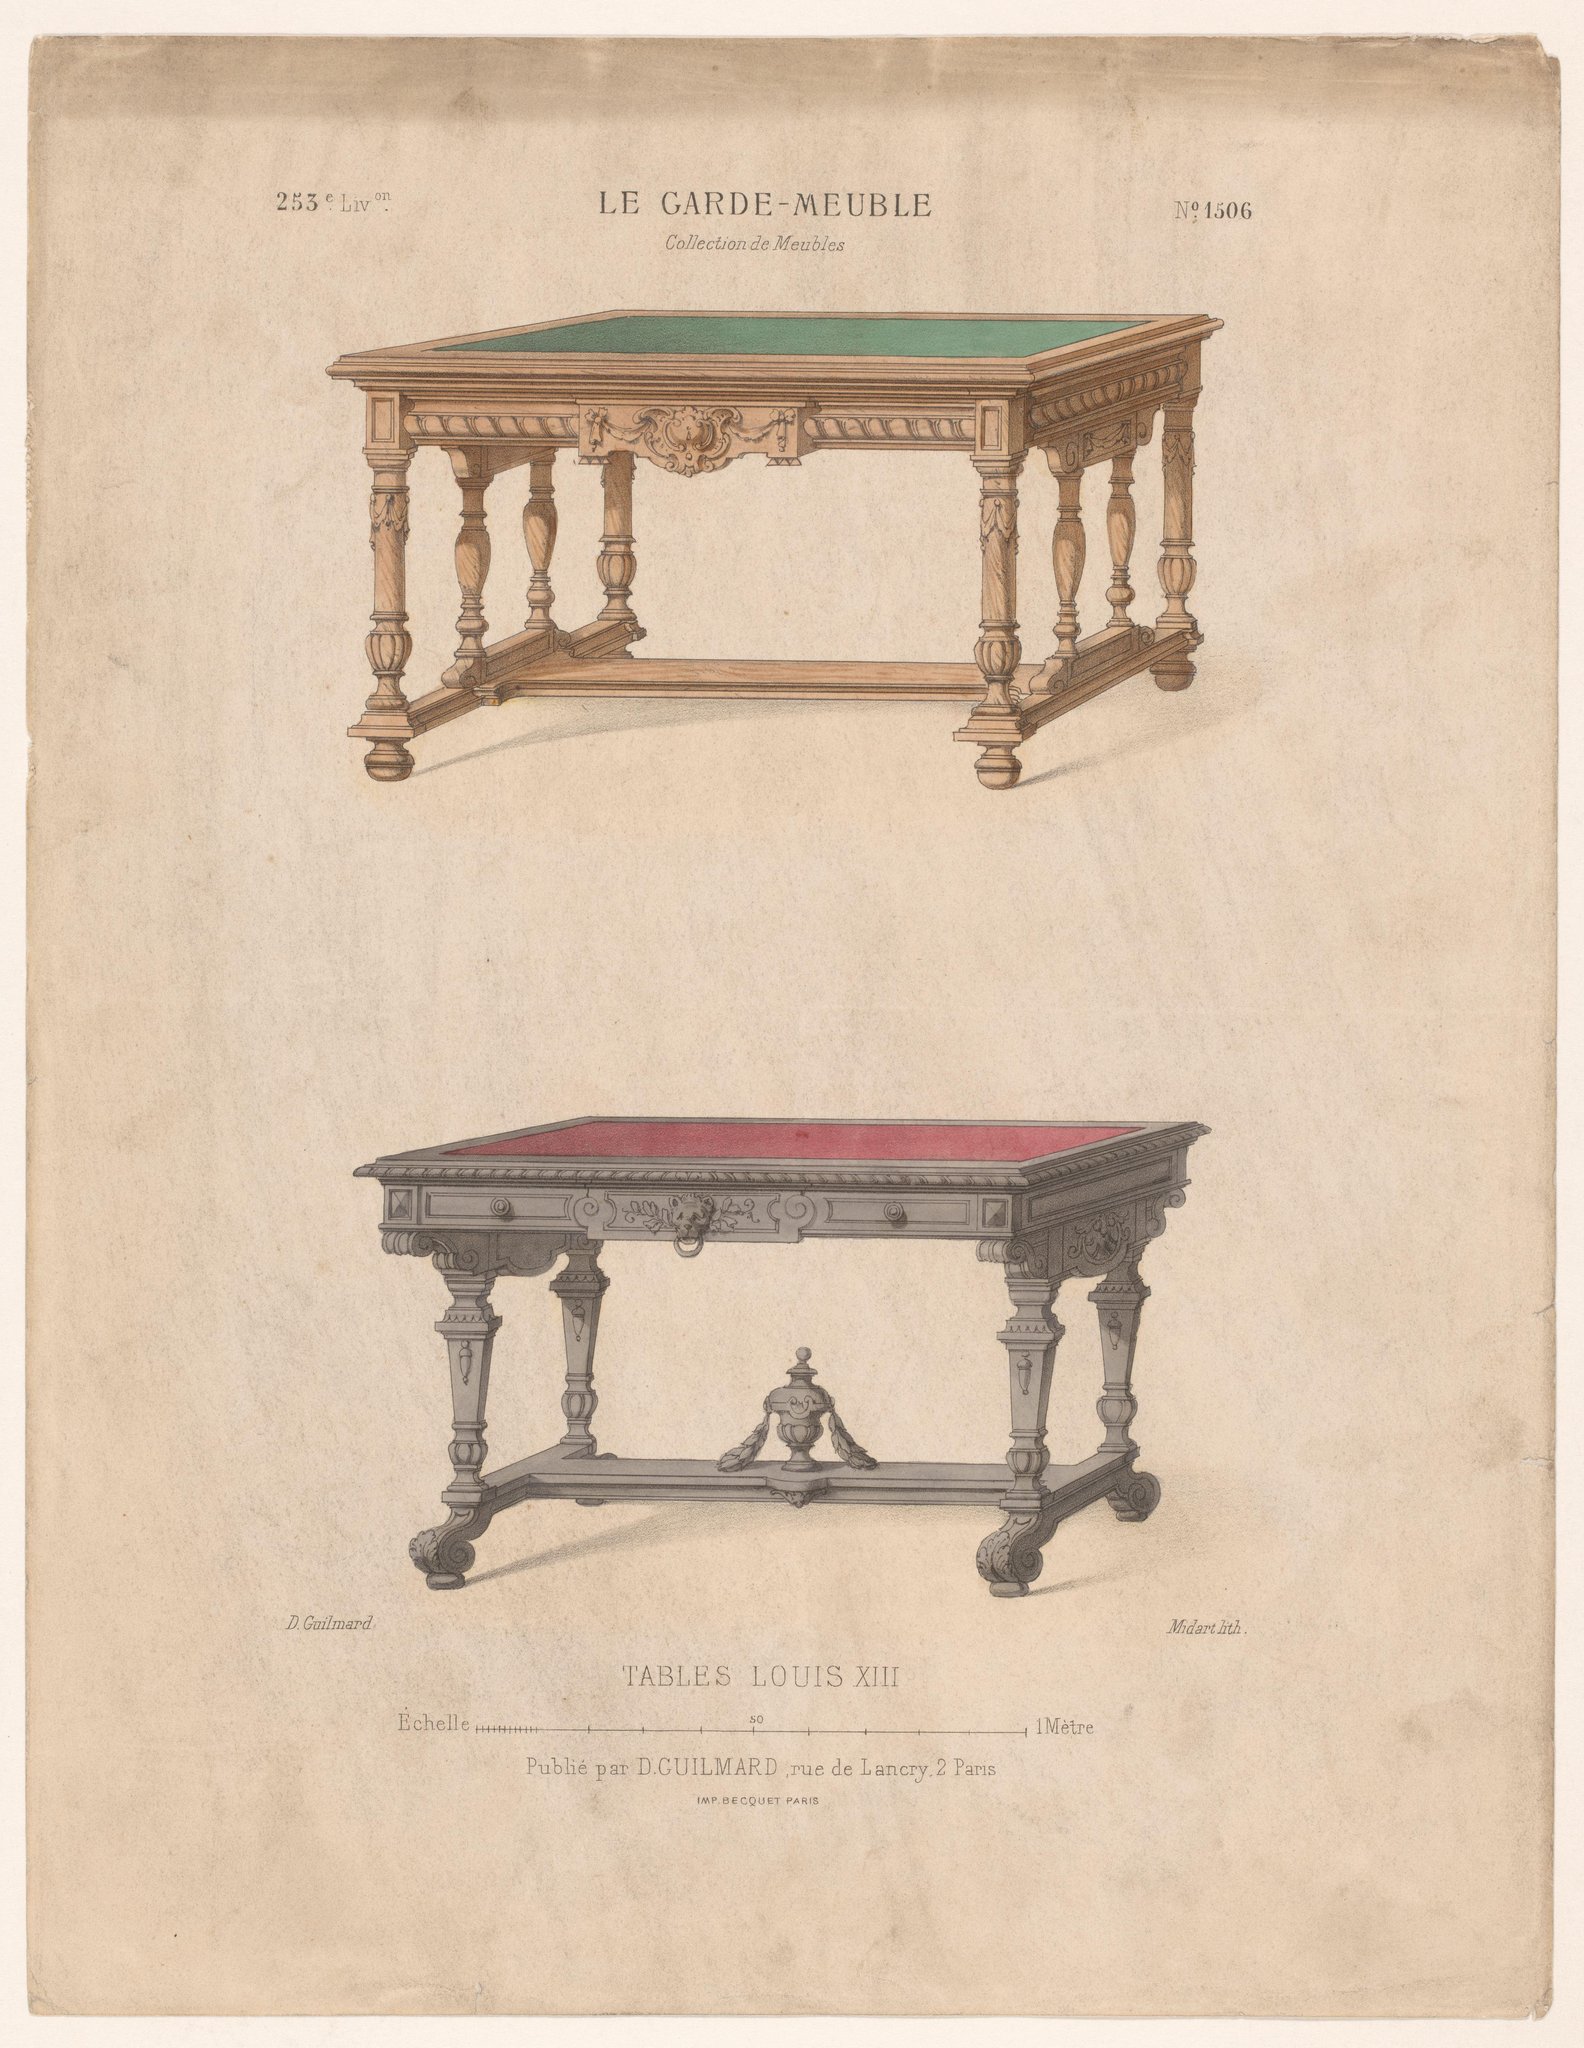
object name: print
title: Twee tafels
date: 1839-1885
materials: paper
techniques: hand coloring, lithograph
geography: paris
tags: table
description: Ieder Livraison in de serie Le Garde-Meuble bevat negen platen: drie 'sièges' (zitmeubels), drie 'meubles' (diverse meubels zoals tafels en kasten) en drie 'tentures' (gordijnen en draperieën).